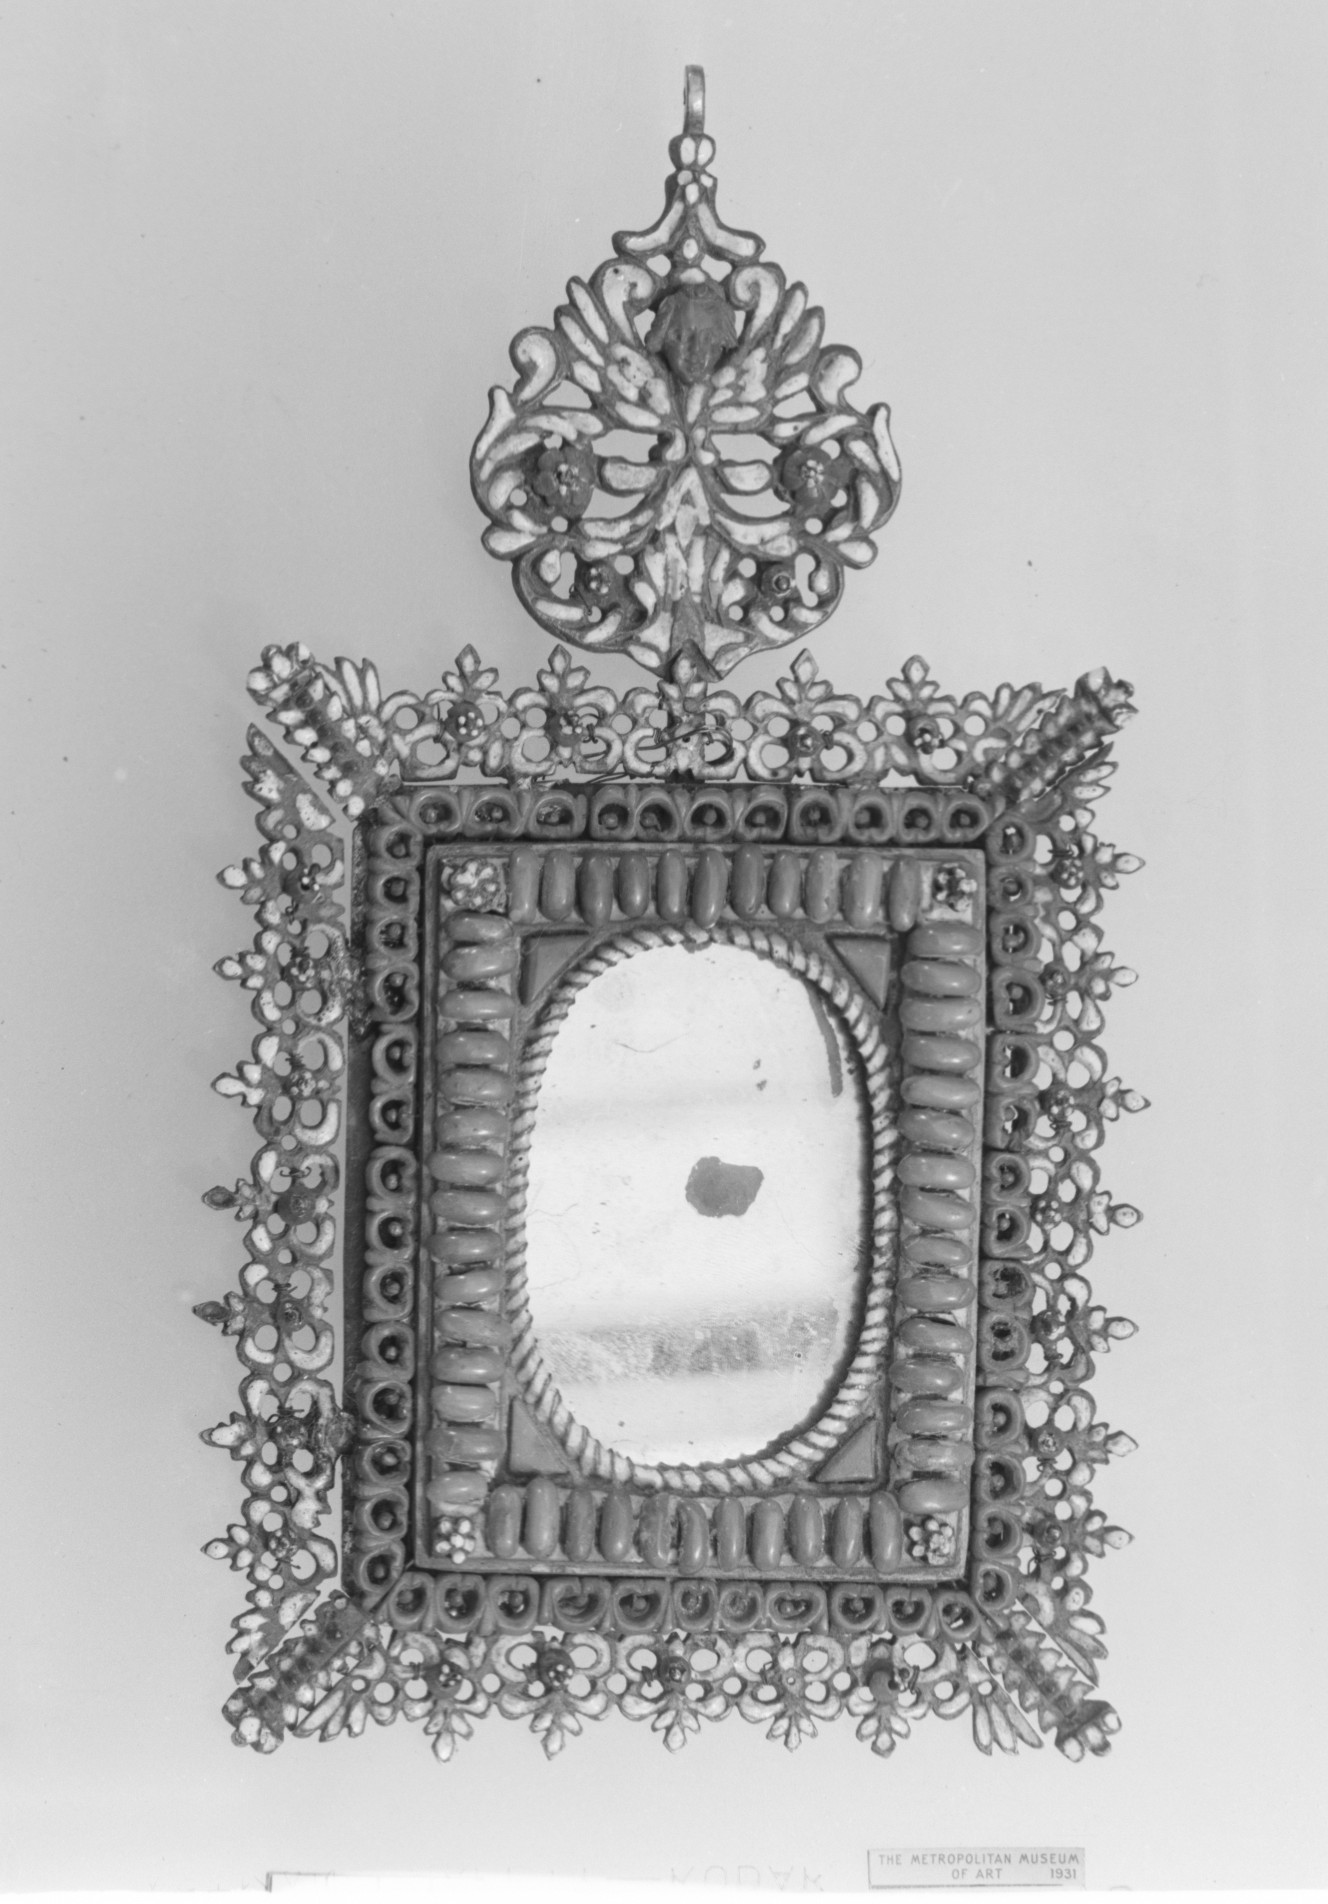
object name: mirror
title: Mirror (one of a pair)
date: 1601-1700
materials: brass, copper, coral, enamel, gilt, glass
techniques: enamel